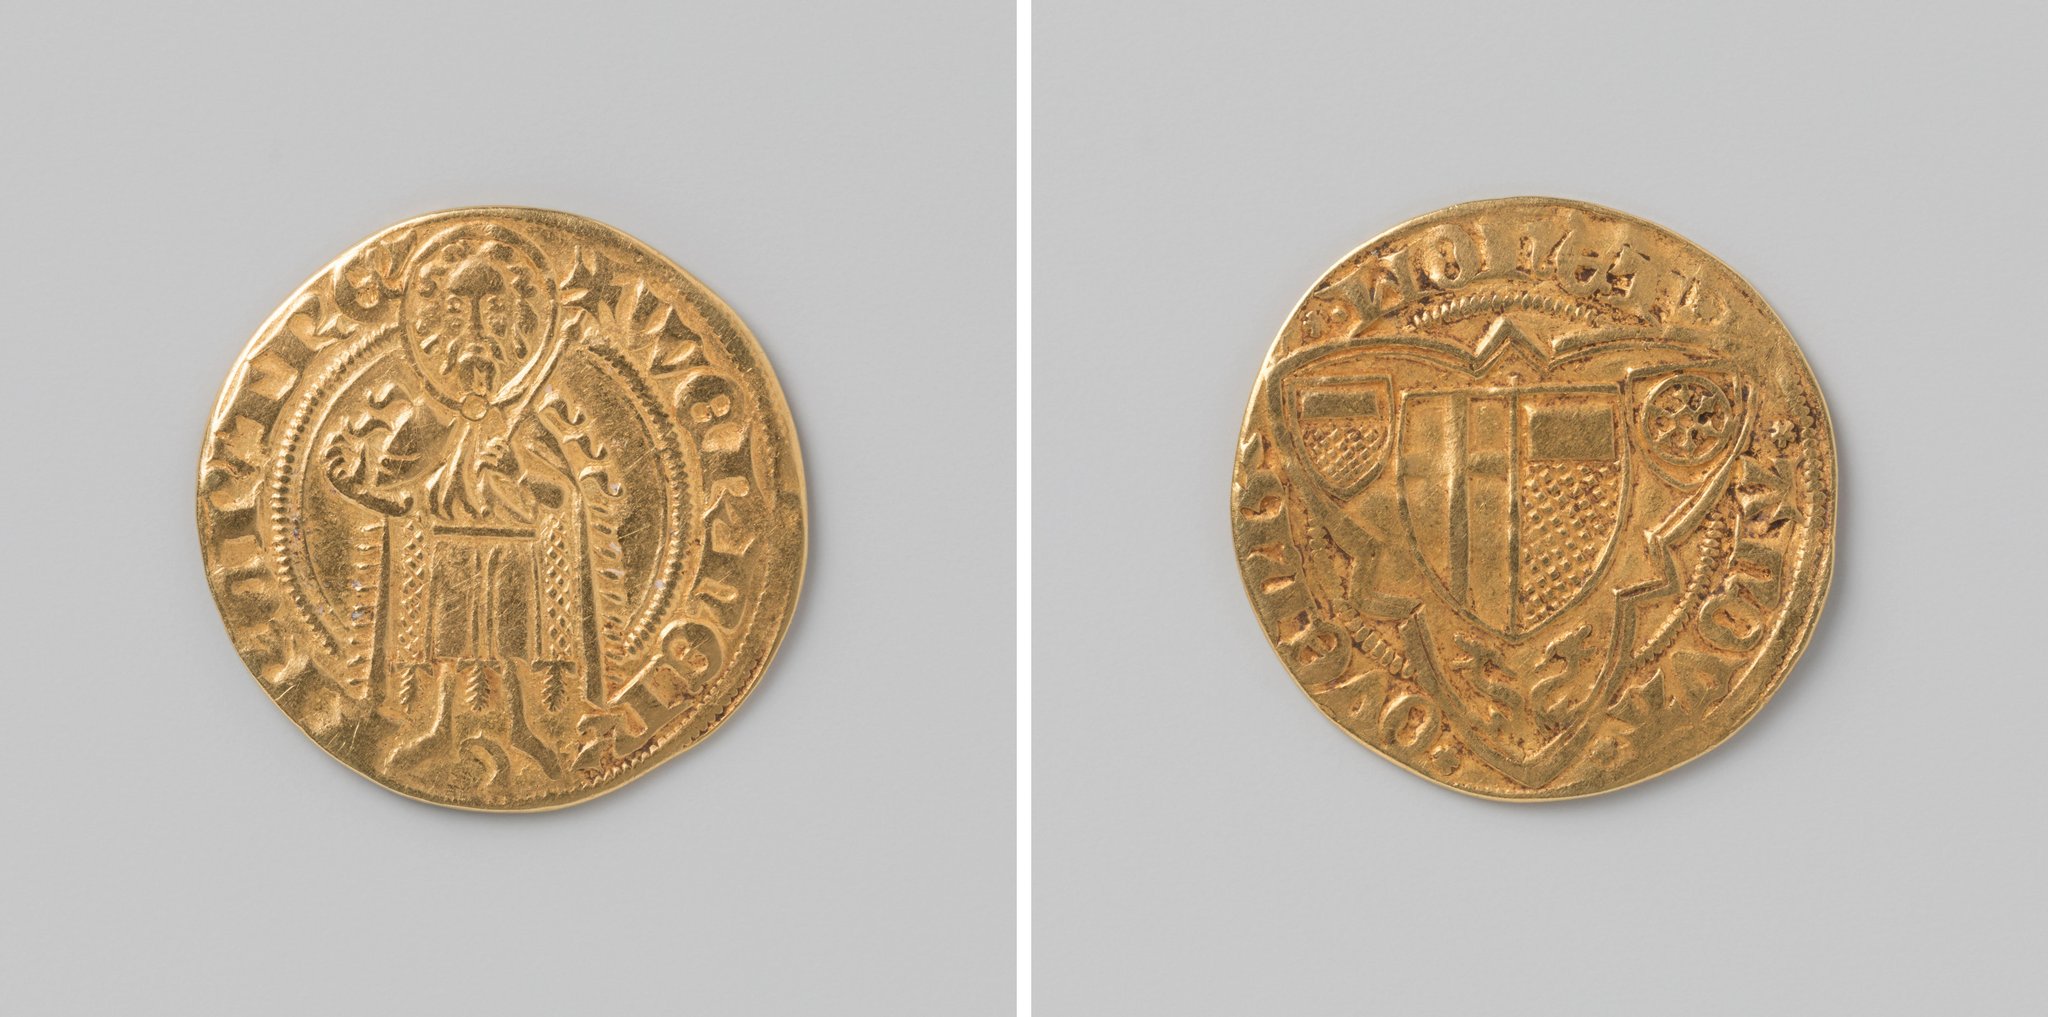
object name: coin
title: Rijnsgulden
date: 1412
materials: gold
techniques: striking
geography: offenbach am main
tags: germany, brielle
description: Opgegraven in de tuin van het in 1557 gestichte Merula-weeshuis te Brielle.